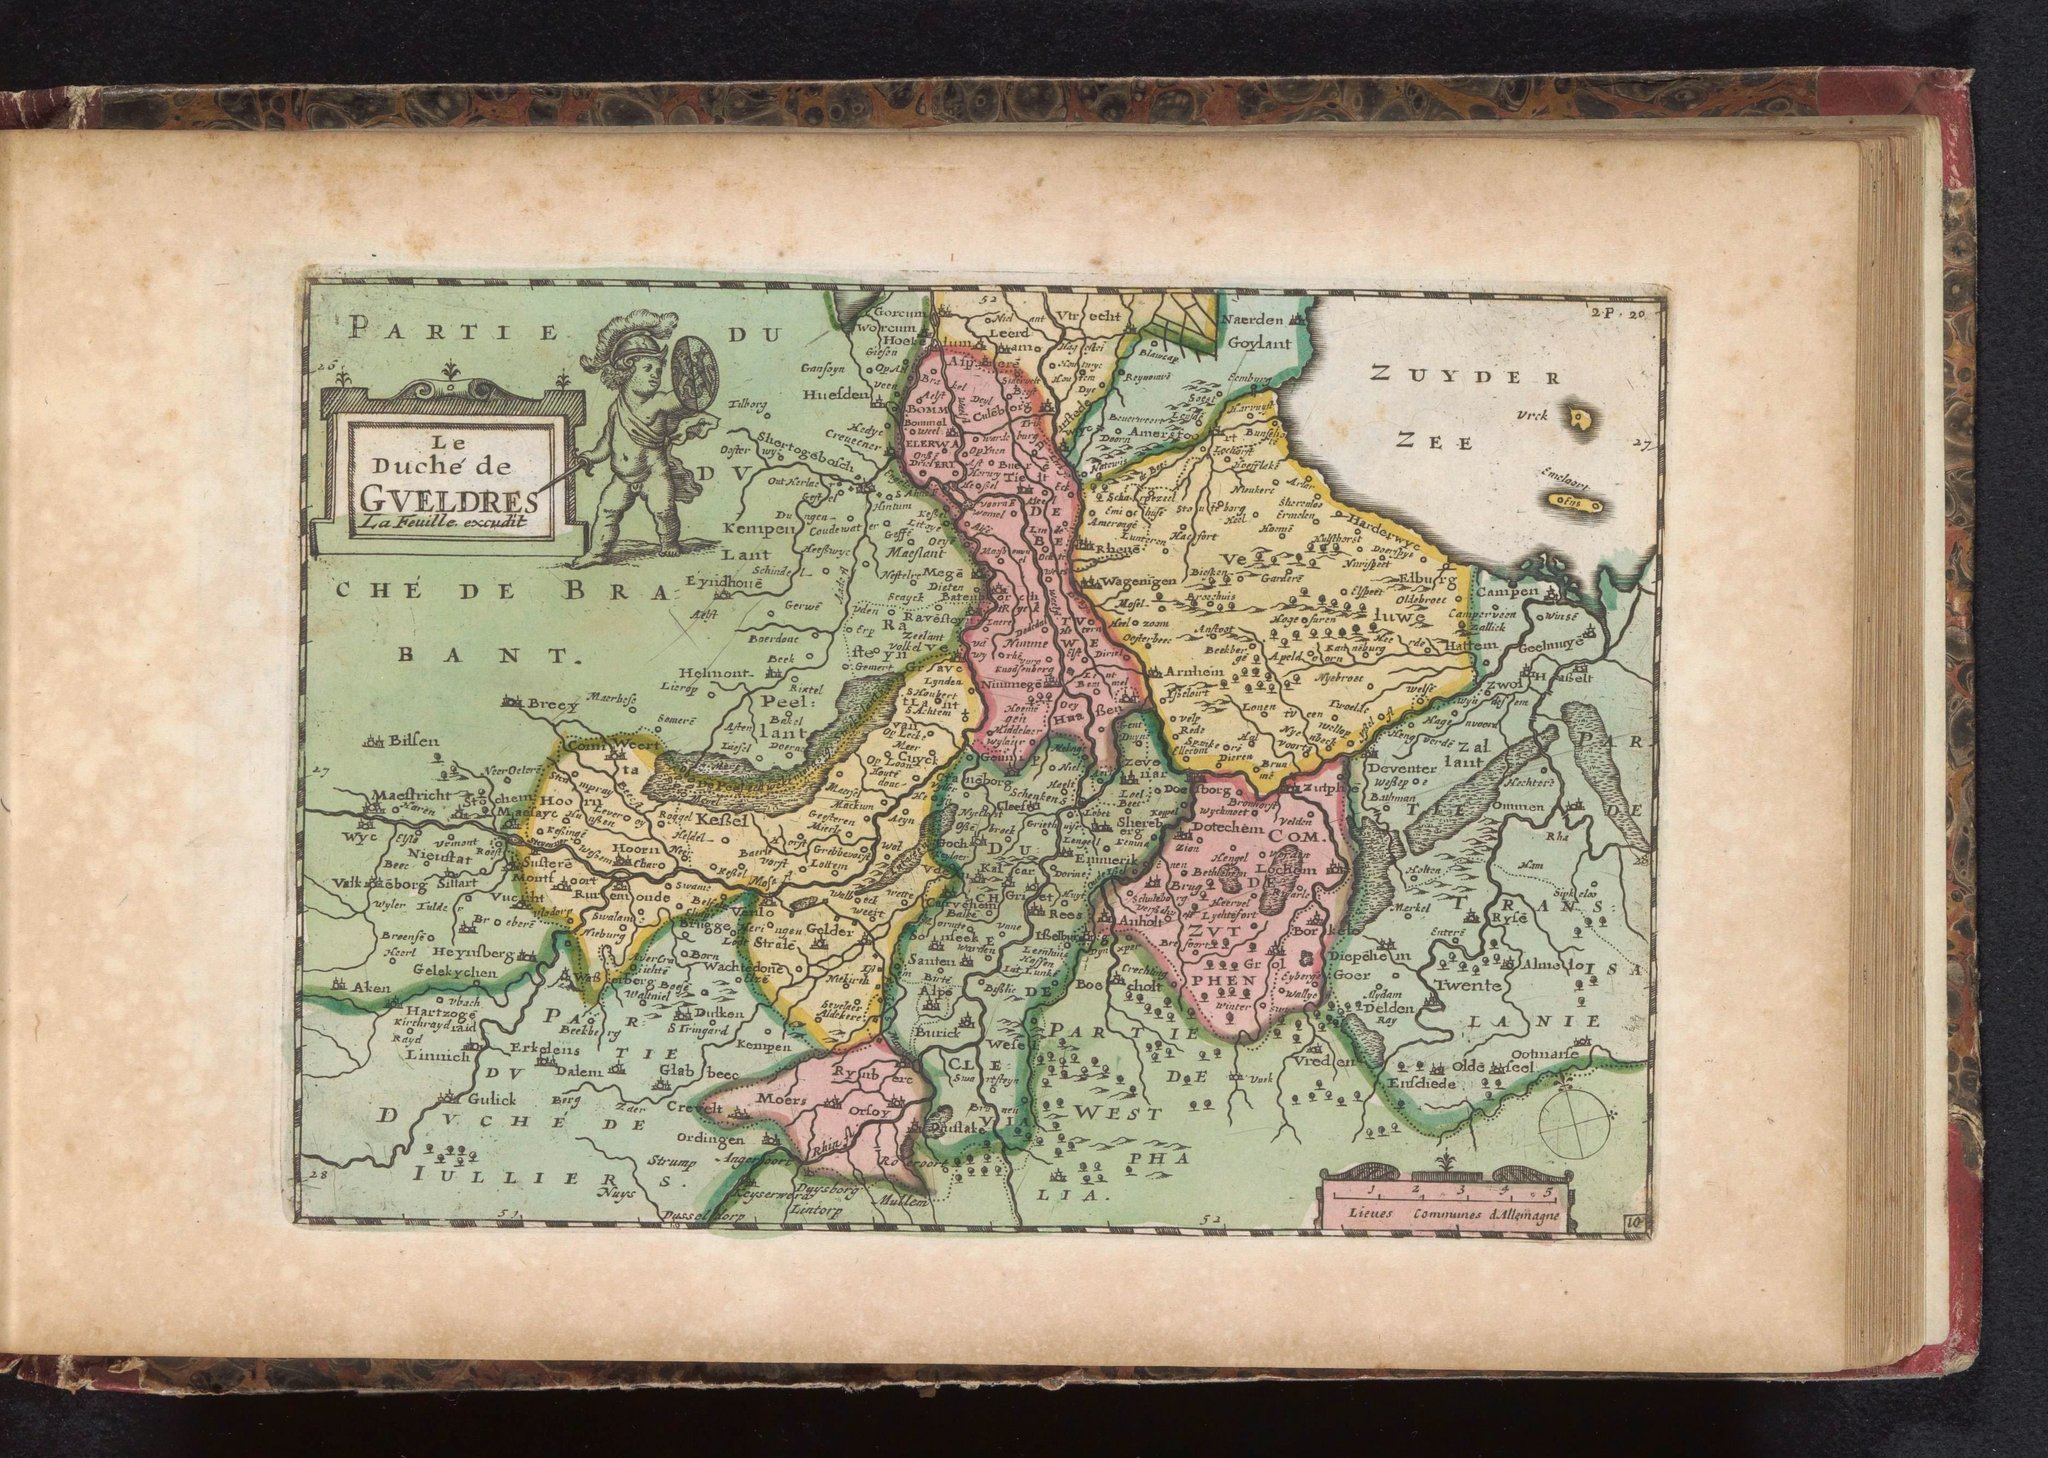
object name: map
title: Le Duché de Gveldres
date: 1700-1702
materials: paper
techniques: engraving, etching, hand coloring, lacquer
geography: northern netherlands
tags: maps of separate countries or regions, guelders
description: Kaart van het hertogdom Gelre, linksboven bij de cartouche met de titel een kindje als soldaat met zwaard en schild met het wapen van Gelre. Onderdeel van een atlas met 223 kaarten van landen en steden en oorlogstaferelen in Europa in de periode ca. 1690-1735.